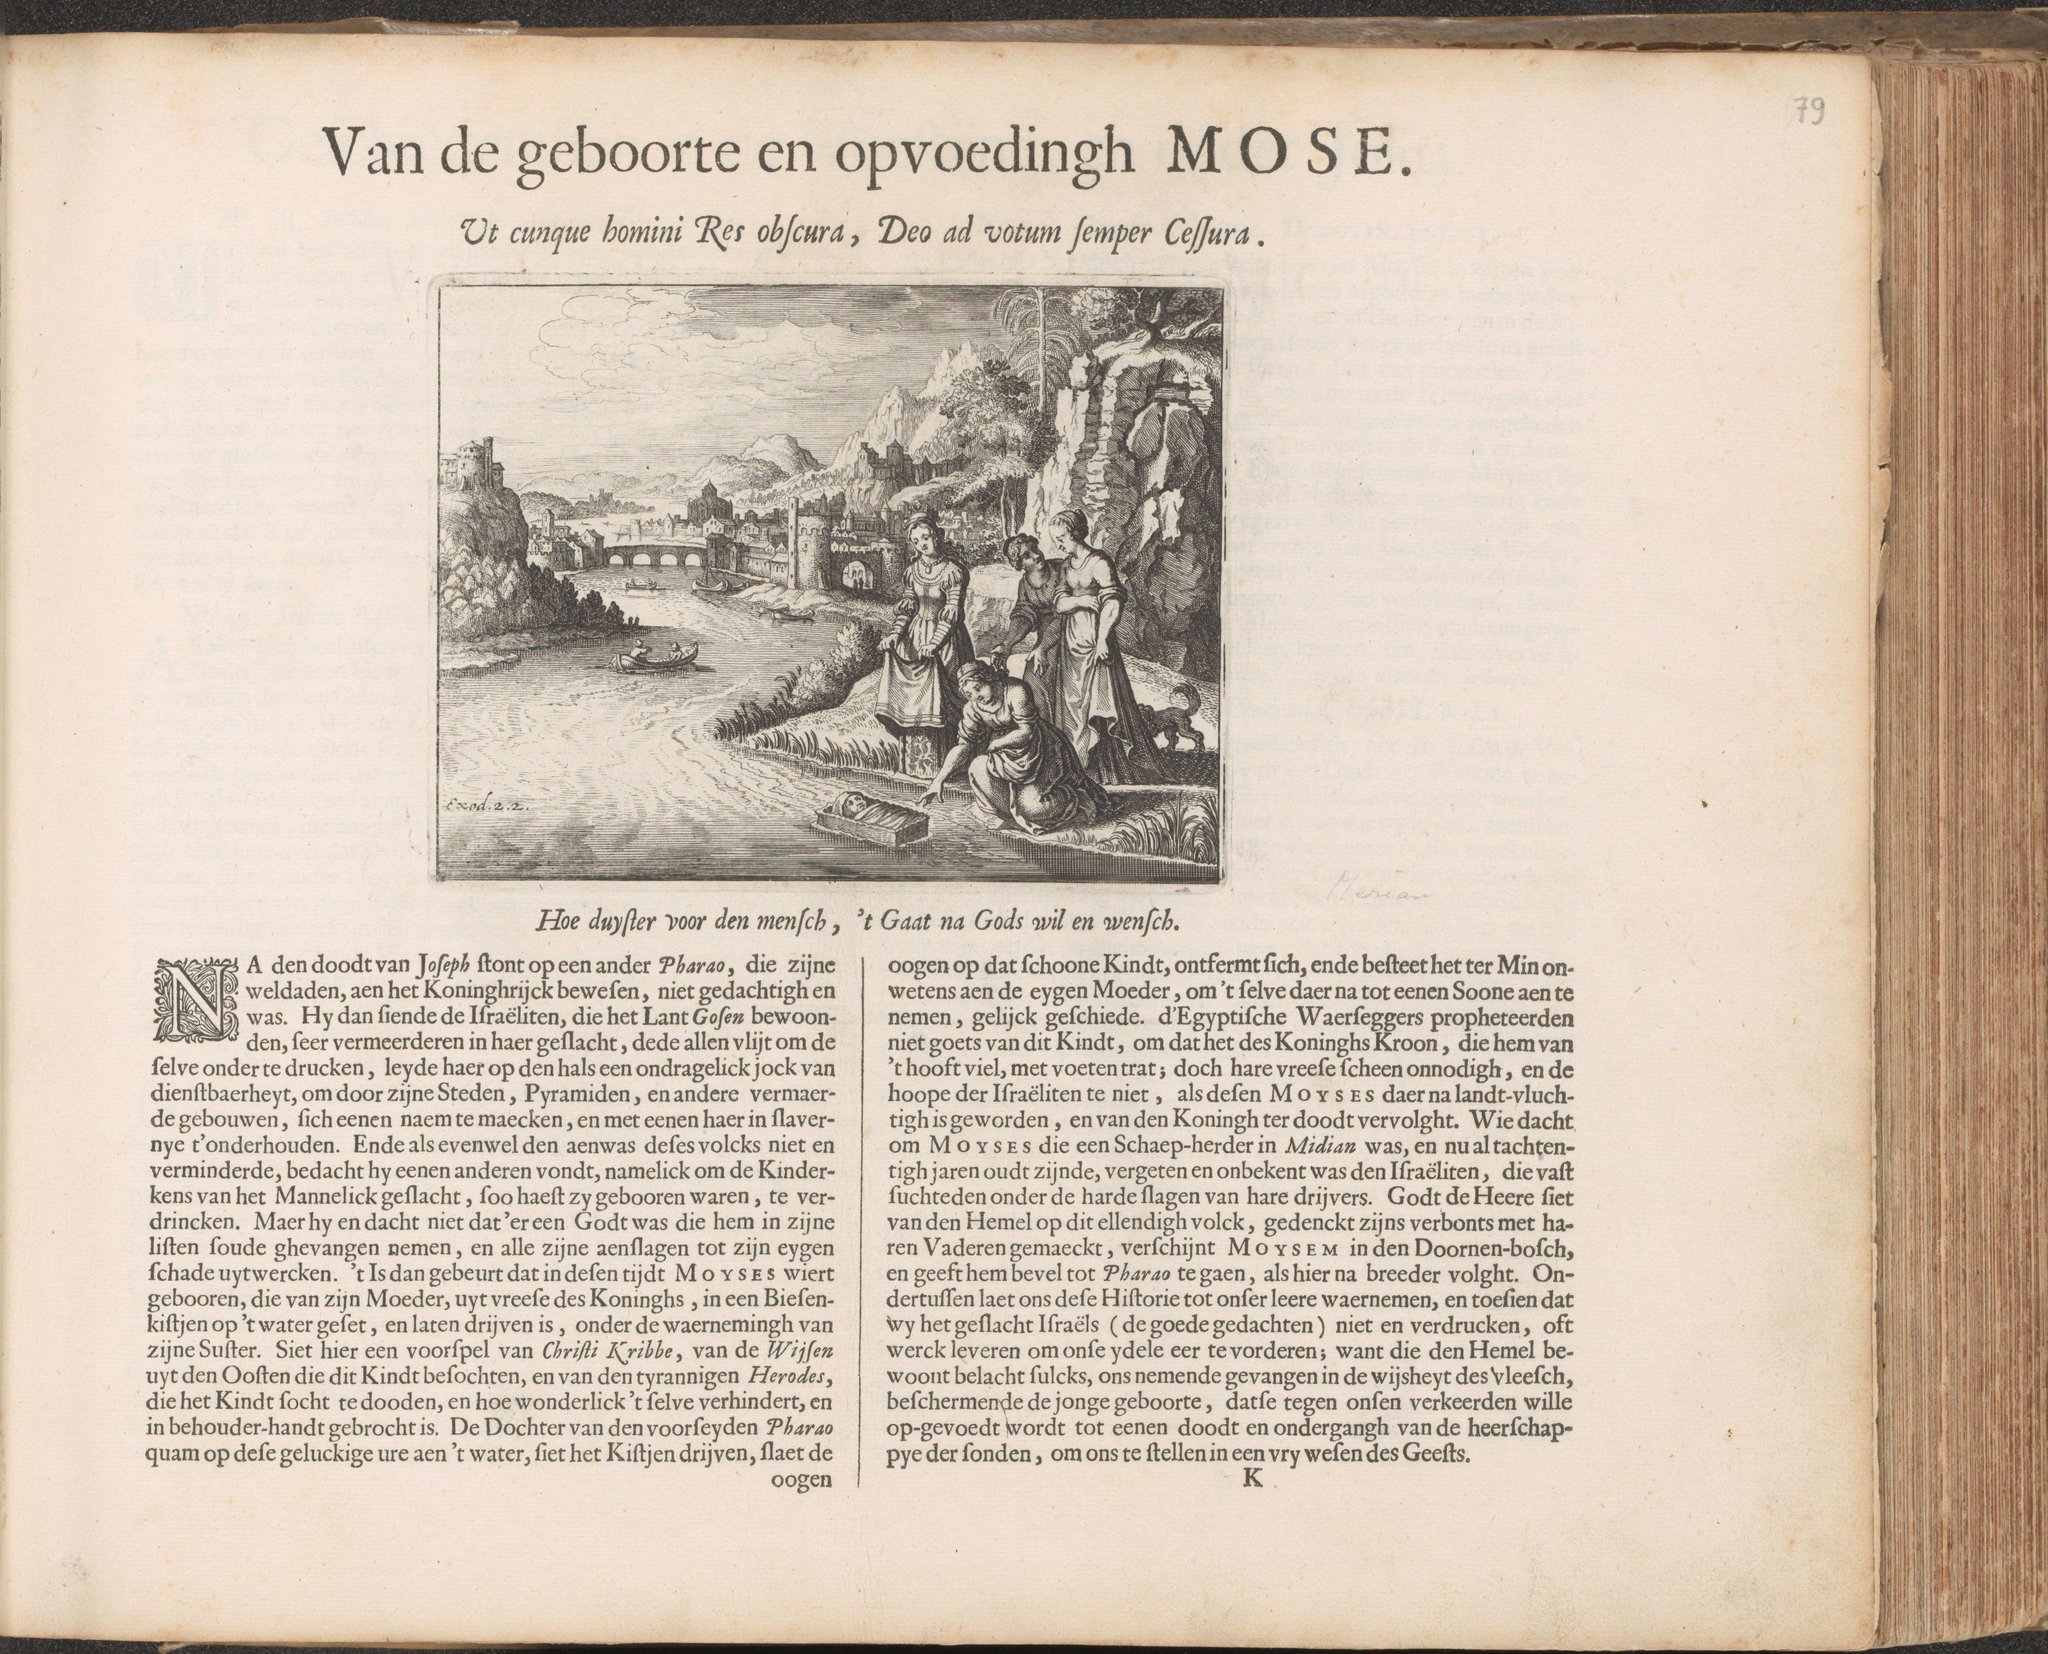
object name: text sheet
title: Den Grooten Emblemata Sacra, bestaande in meer dan vier hondert bybelsche figuren, zoo des Ouden als des Nieuwen Testaments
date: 1630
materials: paper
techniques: etching, letterpress printing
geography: amsterdam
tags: the finding of moses: pharaoh's daughter comes to bathe with her maidens in the river and discovers the child floating on the water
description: Mozes wordt in een biezen mandje op de rivier gevonden door de dochter van de farao en haar dienaressen. Een van de vrouwen zit op haar hurken en probeert het mandje te pakken. Links een verwijzing naar de betreffende Bijbeltekst: Exod. 2:2. De begeleidende tekst begint met een kleine gedecoreerde initiaal N. Daarbij een motto in het Latijn en het Nederlands: hoe duyster voor den mensch, 't gaat na Gods wil en wensch. Het blad maakt deel uit van een album.